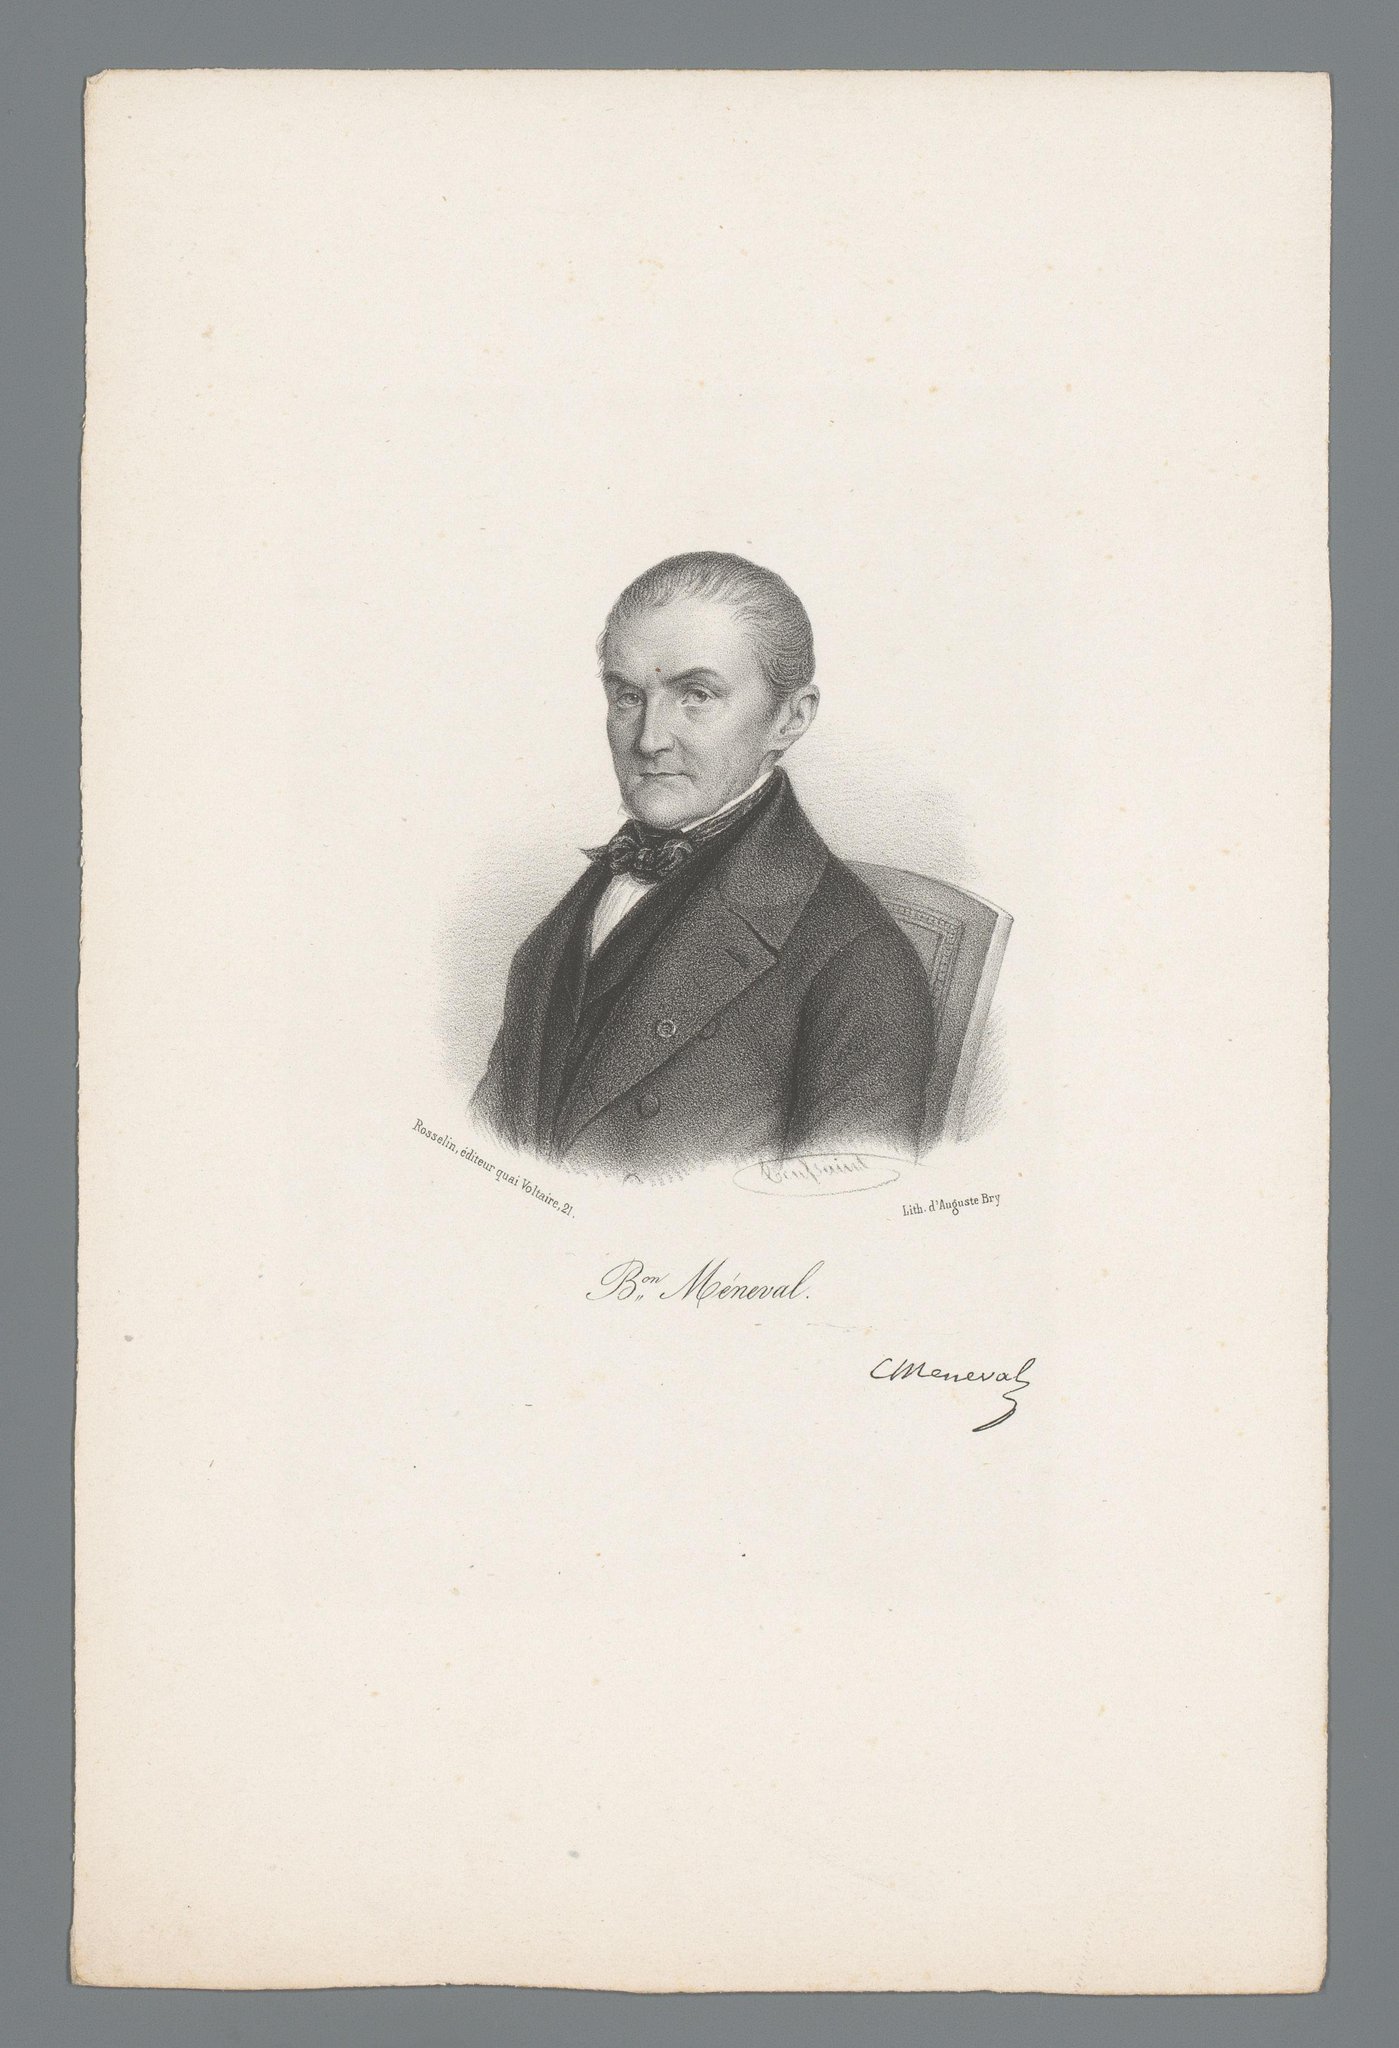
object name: print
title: Bon. Méneval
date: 1847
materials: paper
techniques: lithograph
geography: paris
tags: historical persons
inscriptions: collector's mark: Lugt 2228